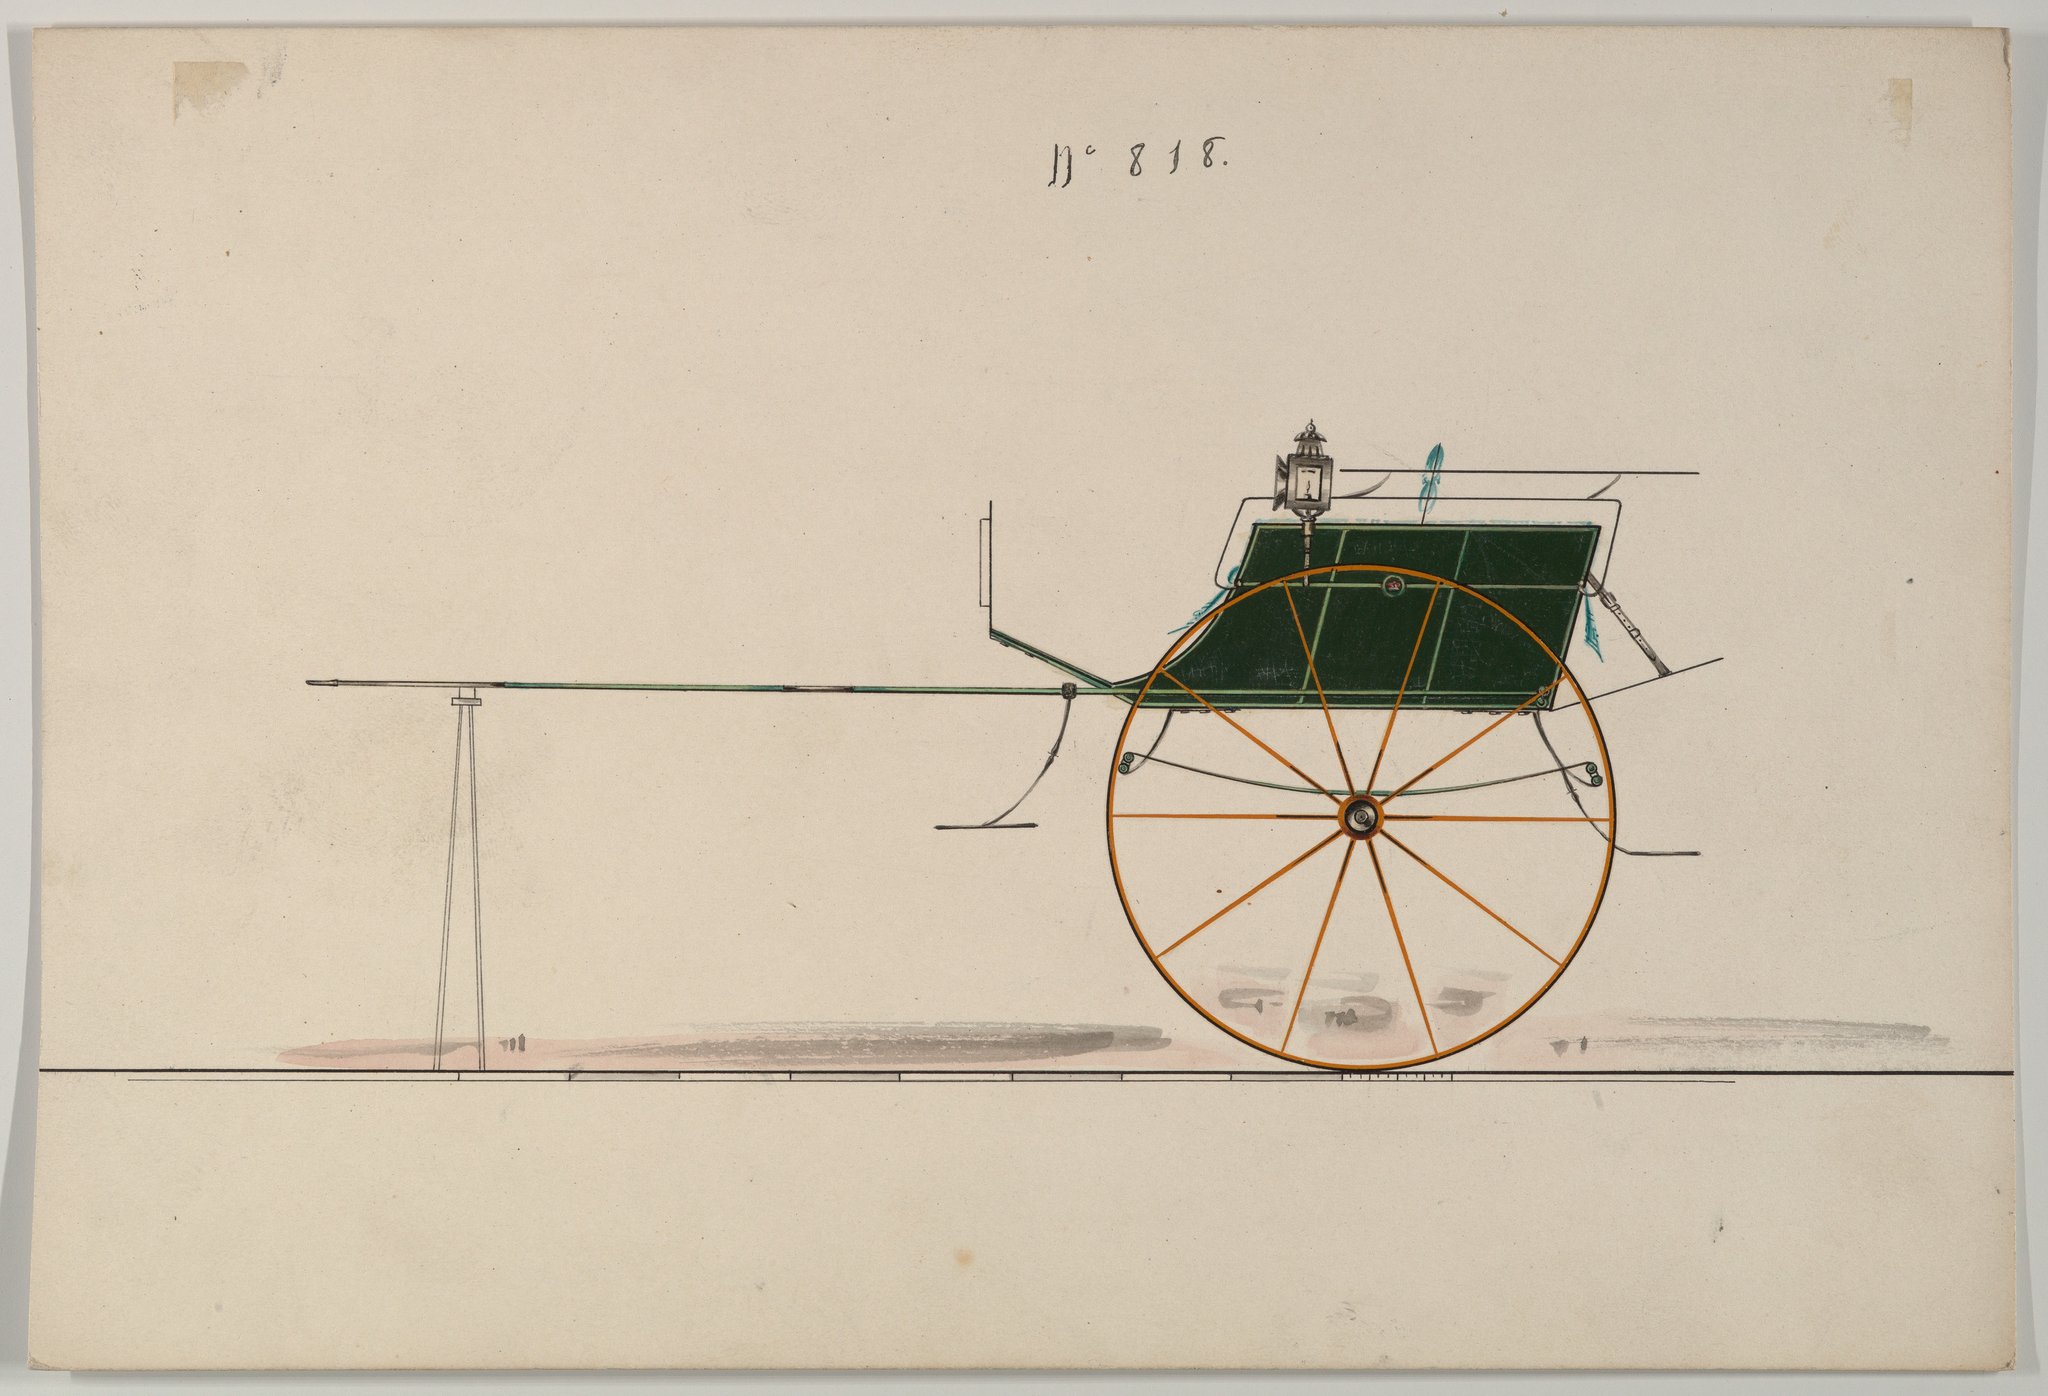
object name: drawing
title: Whitechapel Cart # 818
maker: brewster & co.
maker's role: manufacturer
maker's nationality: american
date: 1870-1874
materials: gouache, gum arabic, ink, watercolor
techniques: pen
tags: carriages